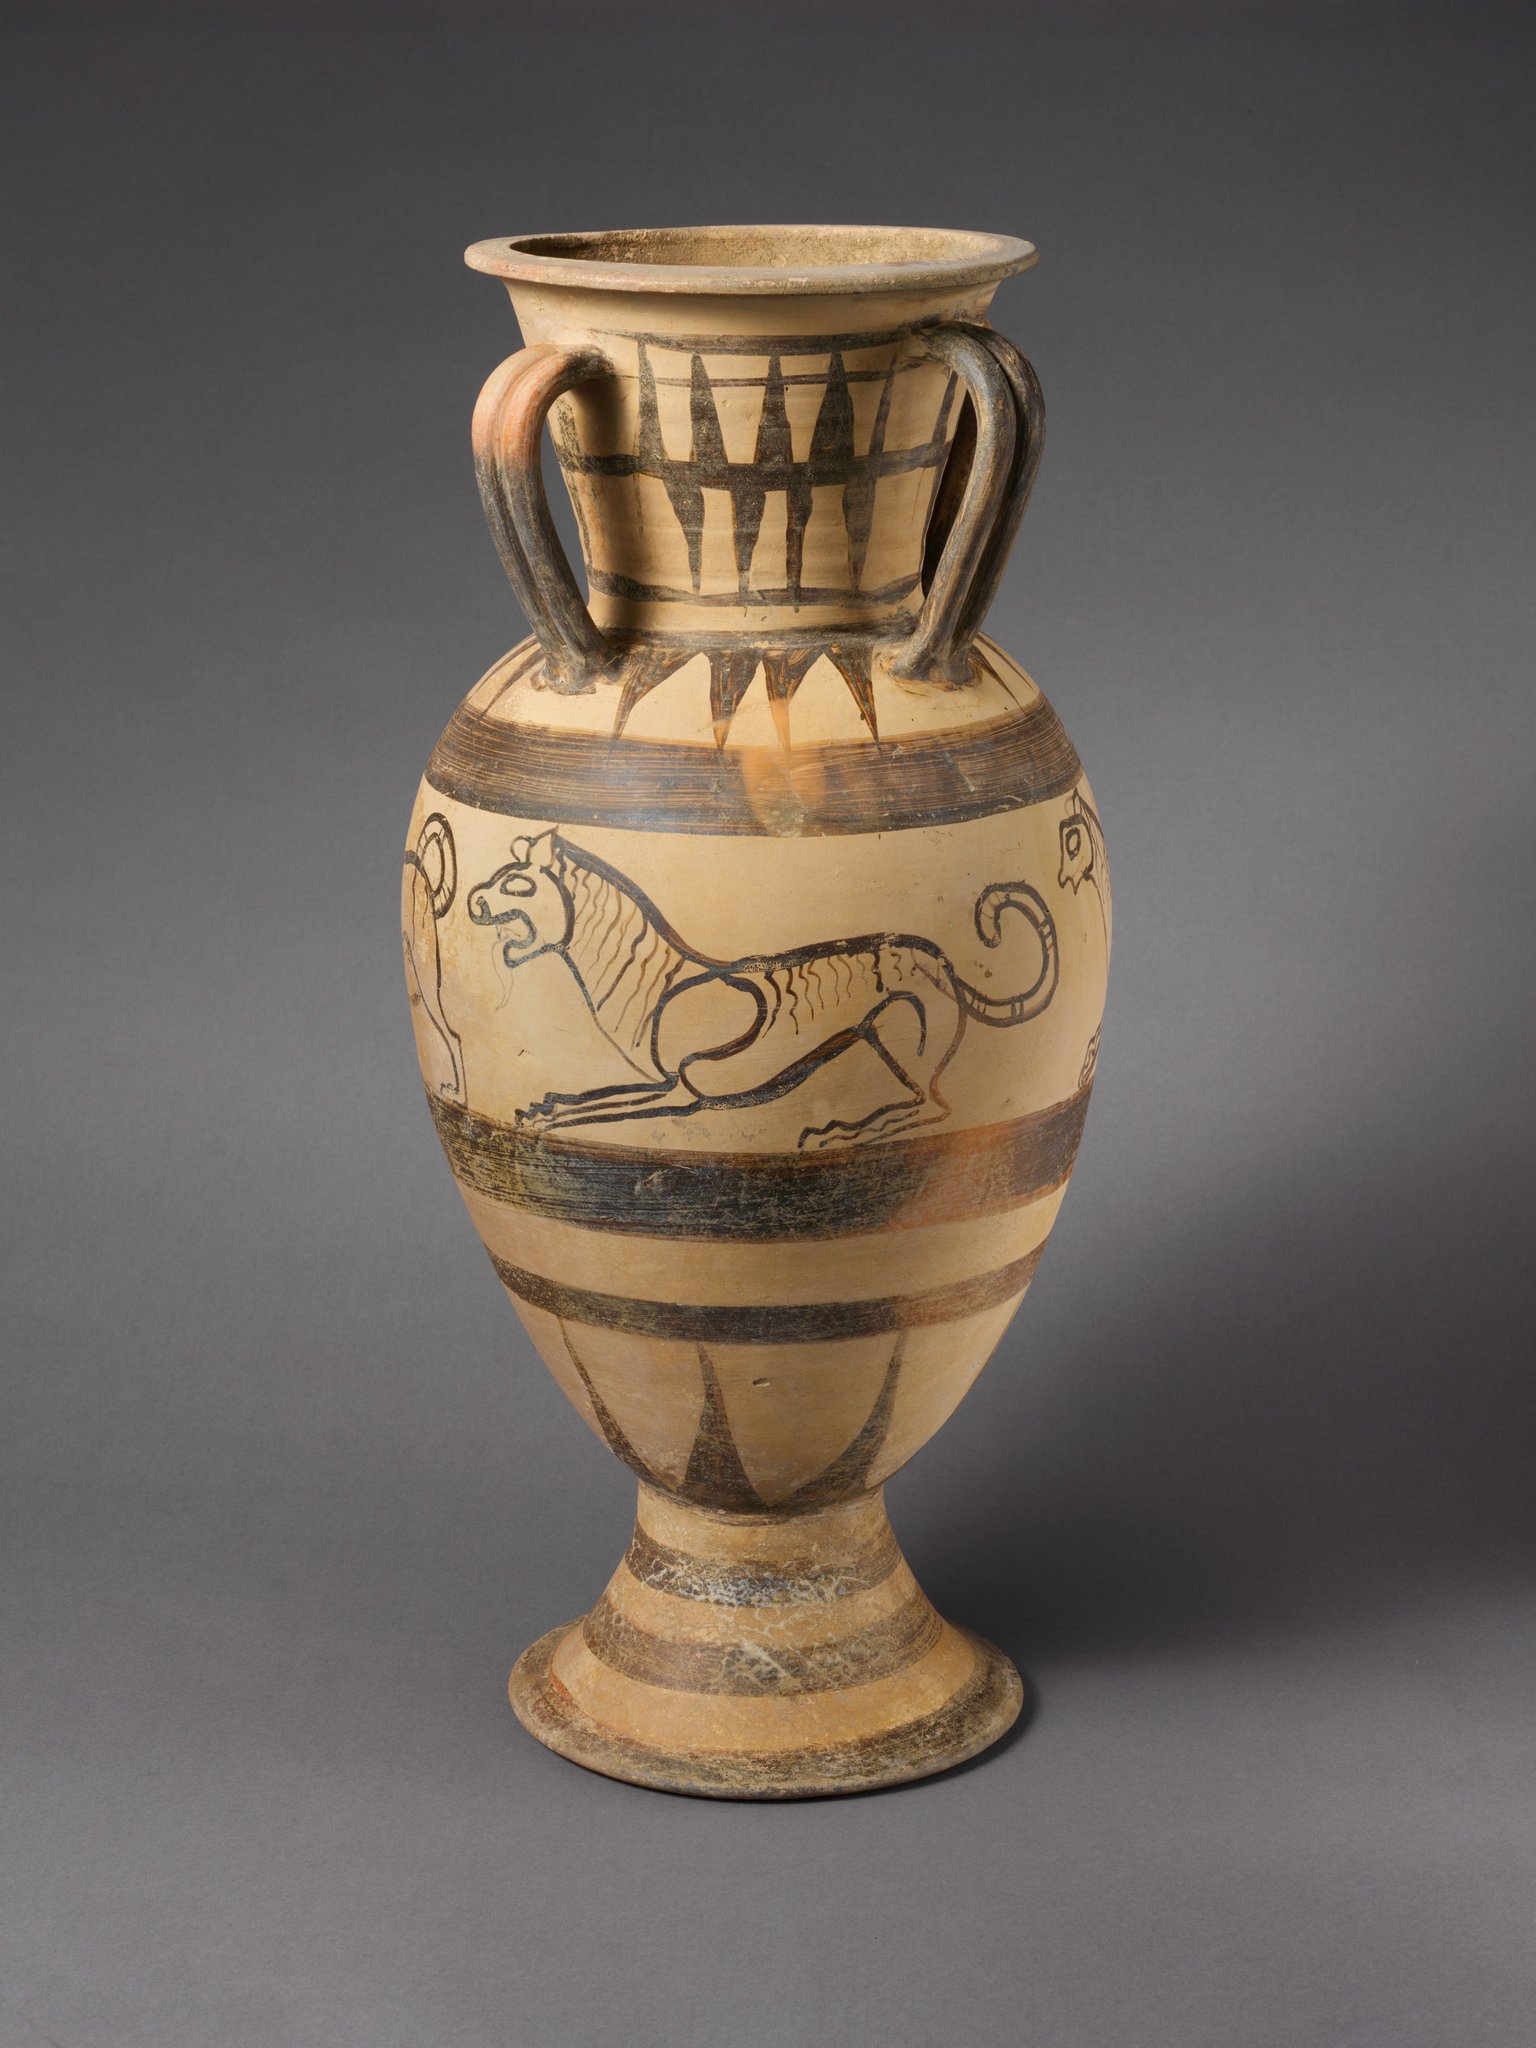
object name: vase with four handle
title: Terracotta four-handled amphora (jar)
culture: etruscan, italo-corinthian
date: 675-650 BCE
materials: terracotta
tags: animals